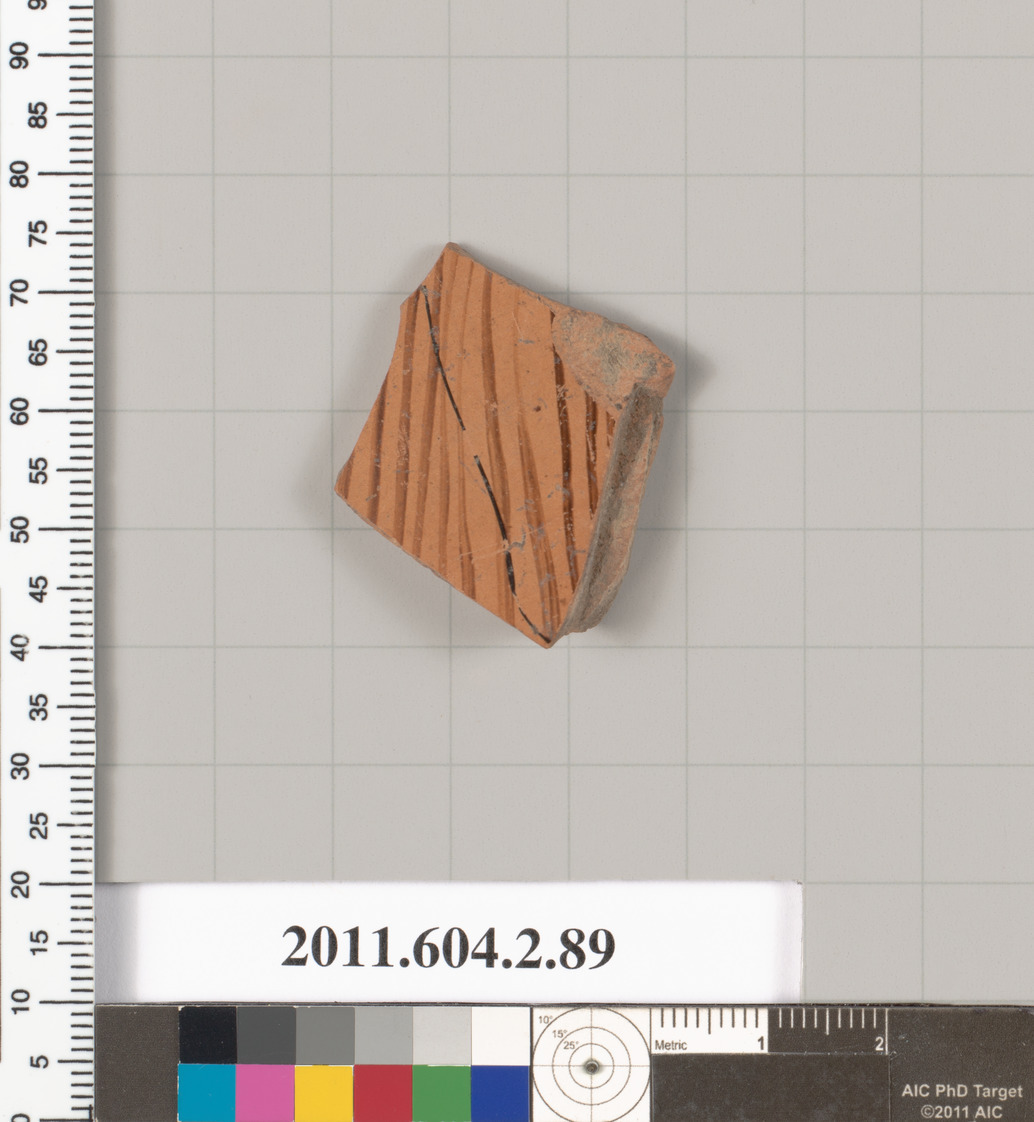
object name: pelike fragment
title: Terracotta fragment of a pelike (jar)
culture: greek, attic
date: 490-480 BCE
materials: terracotta